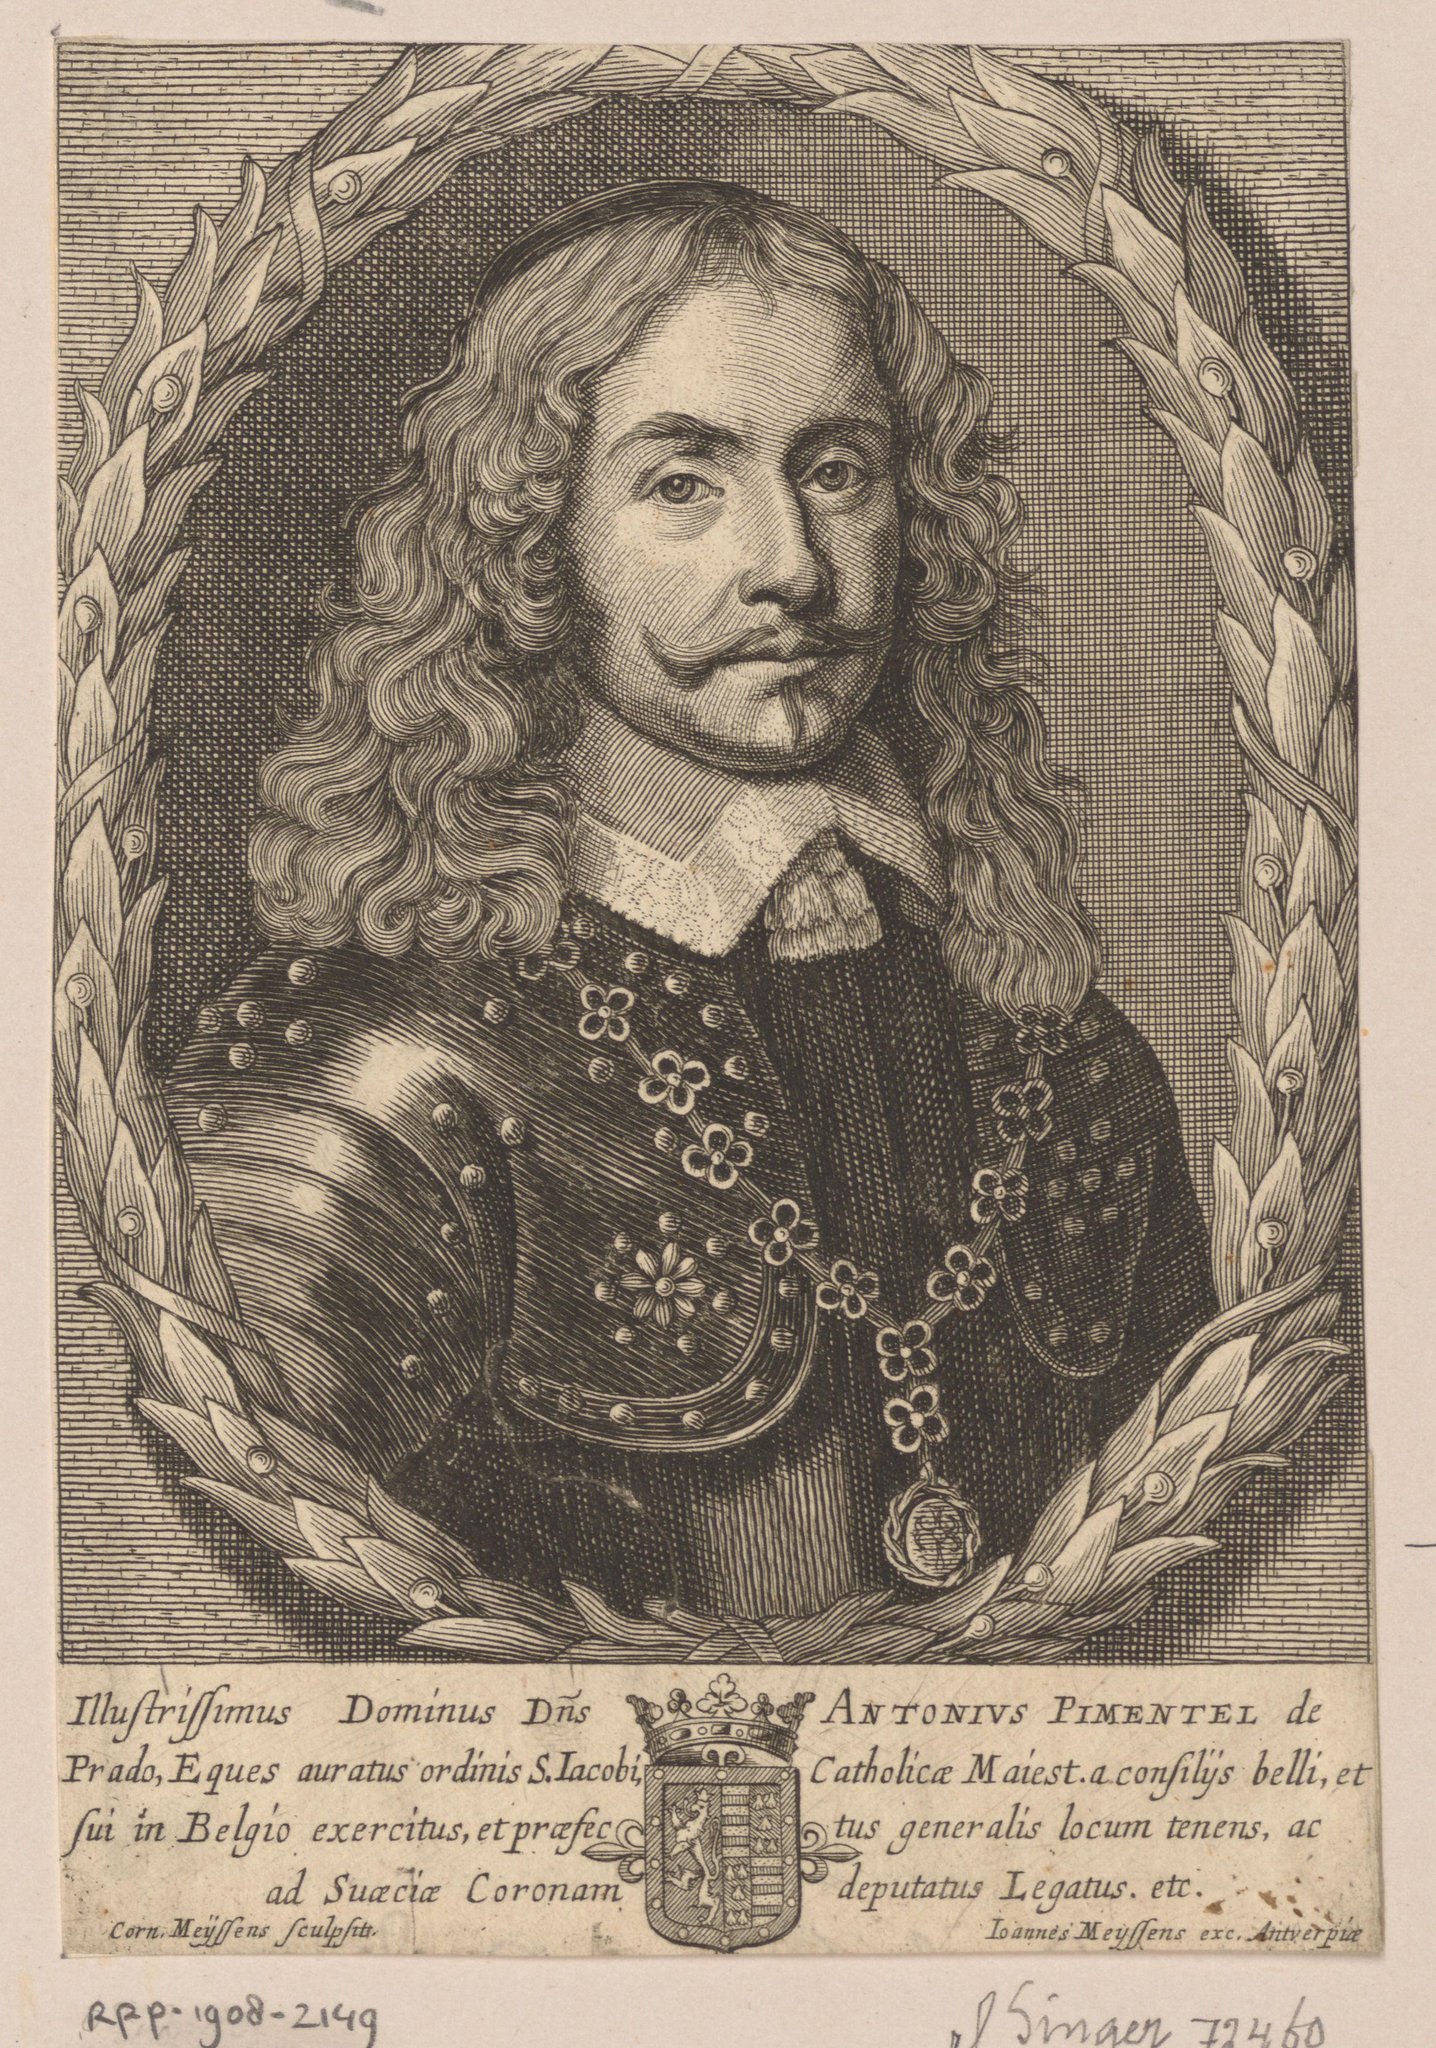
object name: print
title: Portret van Don Antonio Pimentel de Prado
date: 1650-1670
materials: paper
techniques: engraving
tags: adult man, historical persons, armorial bearing, heraldry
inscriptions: collector's mark: Lugt 2228, inscription: ‘N13955’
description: Onder in de marge zijn wapenschild en een vierregelige tekst in het Latijn.